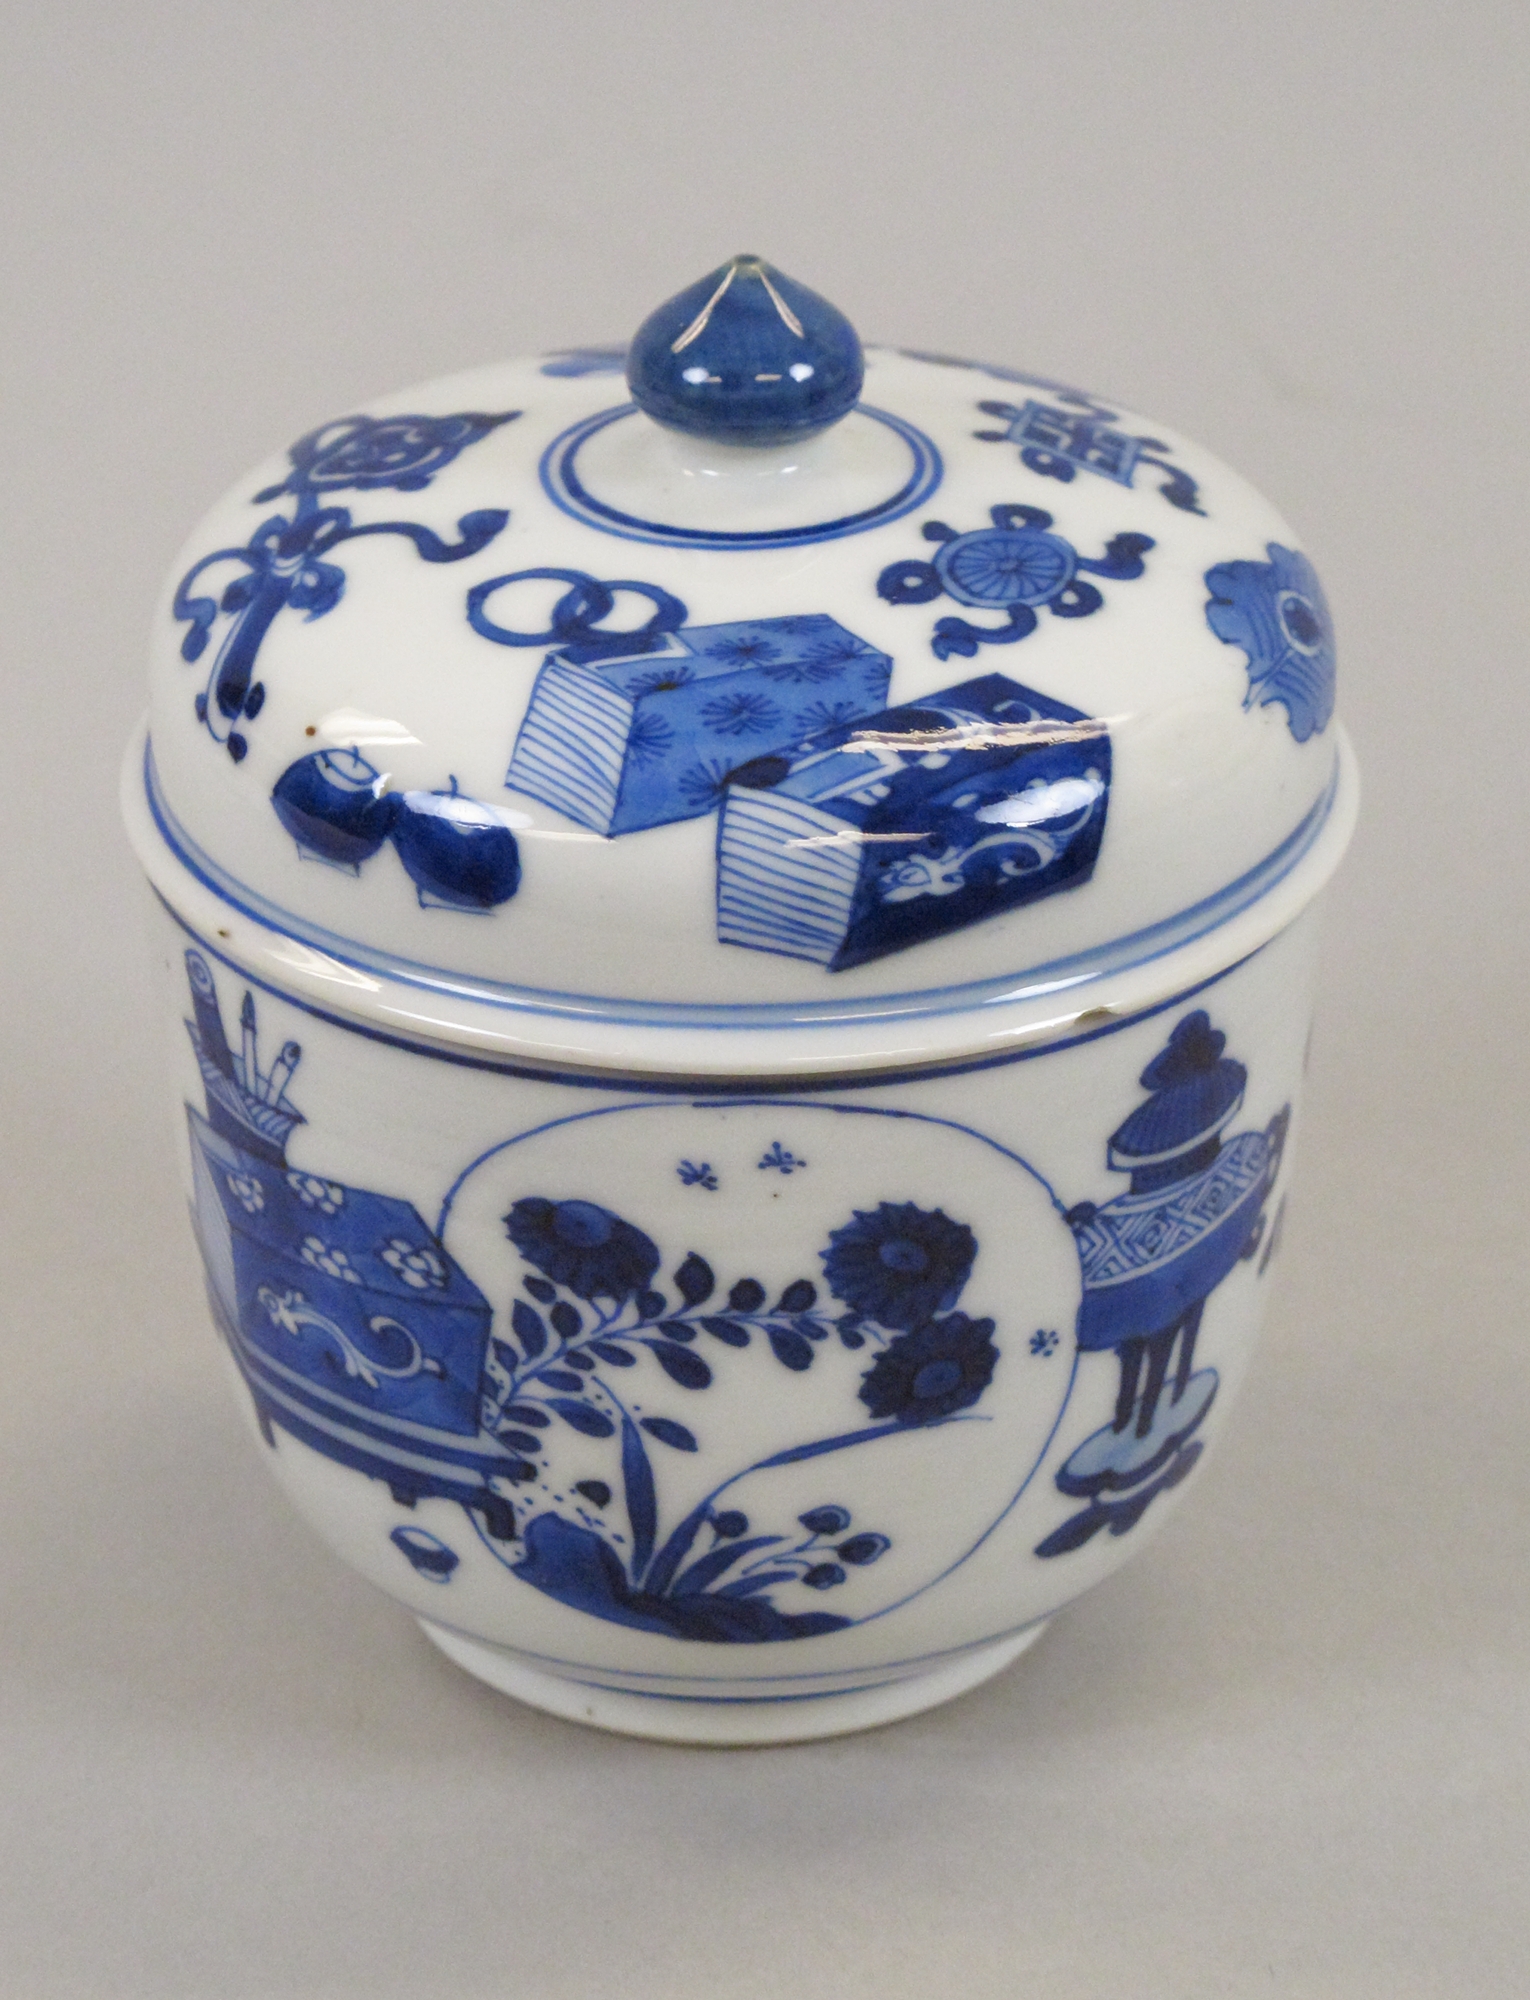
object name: covered jar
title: Covered jar with "Hundred Antique" pattern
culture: chinese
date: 1667-1733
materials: cobalt, porcelain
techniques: painting, underglaze